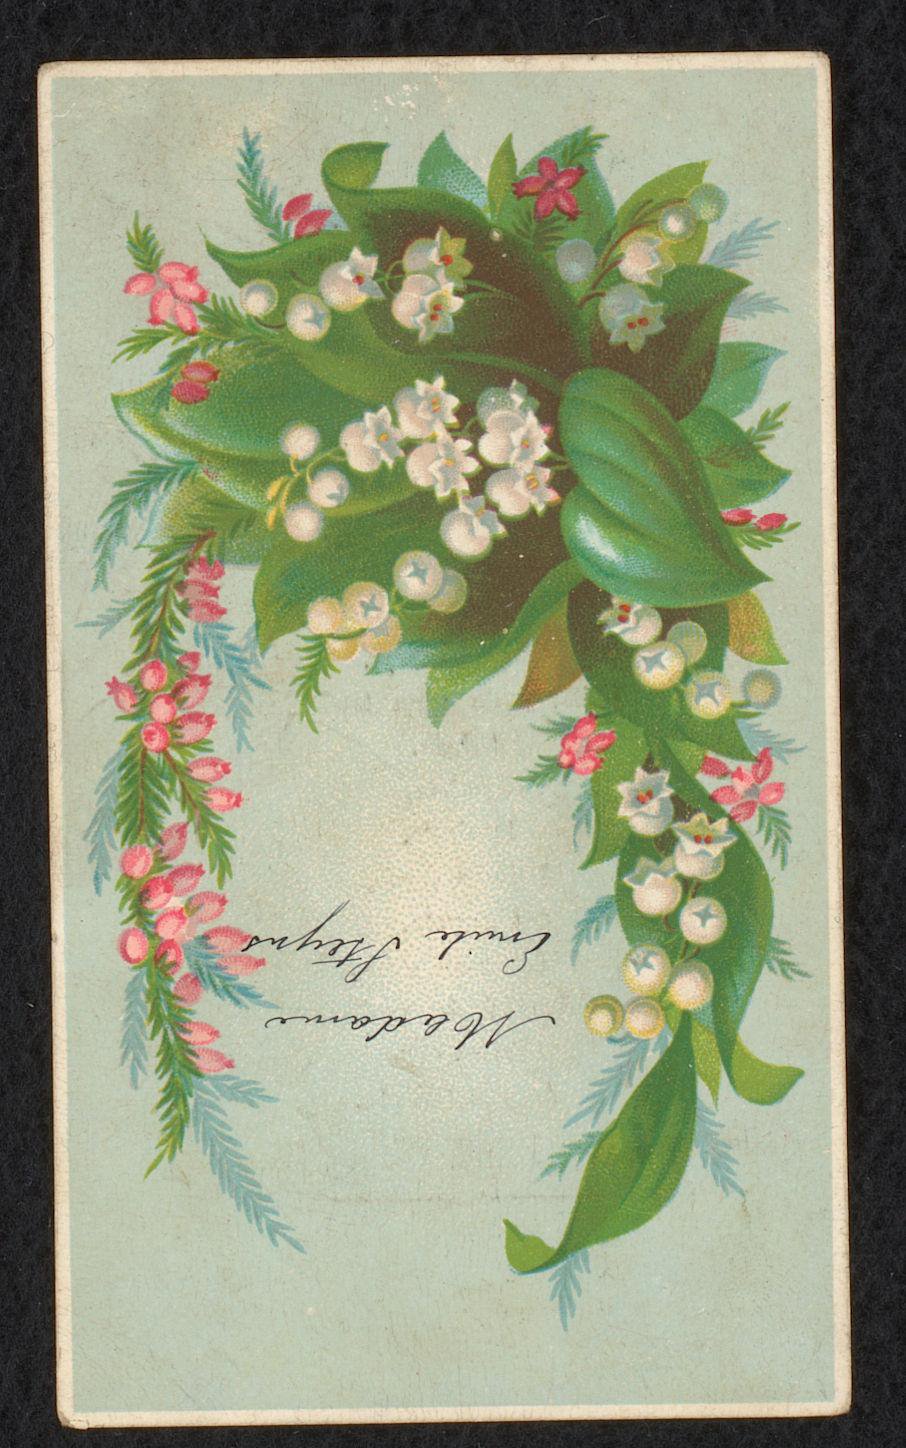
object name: print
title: Menu voor een diner op 22 maart 1885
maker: Anonymous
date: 1885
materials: paper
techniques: lithograph, letterpress printing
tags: lanaken, apotheker, maria van aubel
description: Op de voorzijde een krans van bloemen, met in het midden de naam van de genodigde ('Madame Emile Steyns'). Op de achterzijde het menu van het diner.